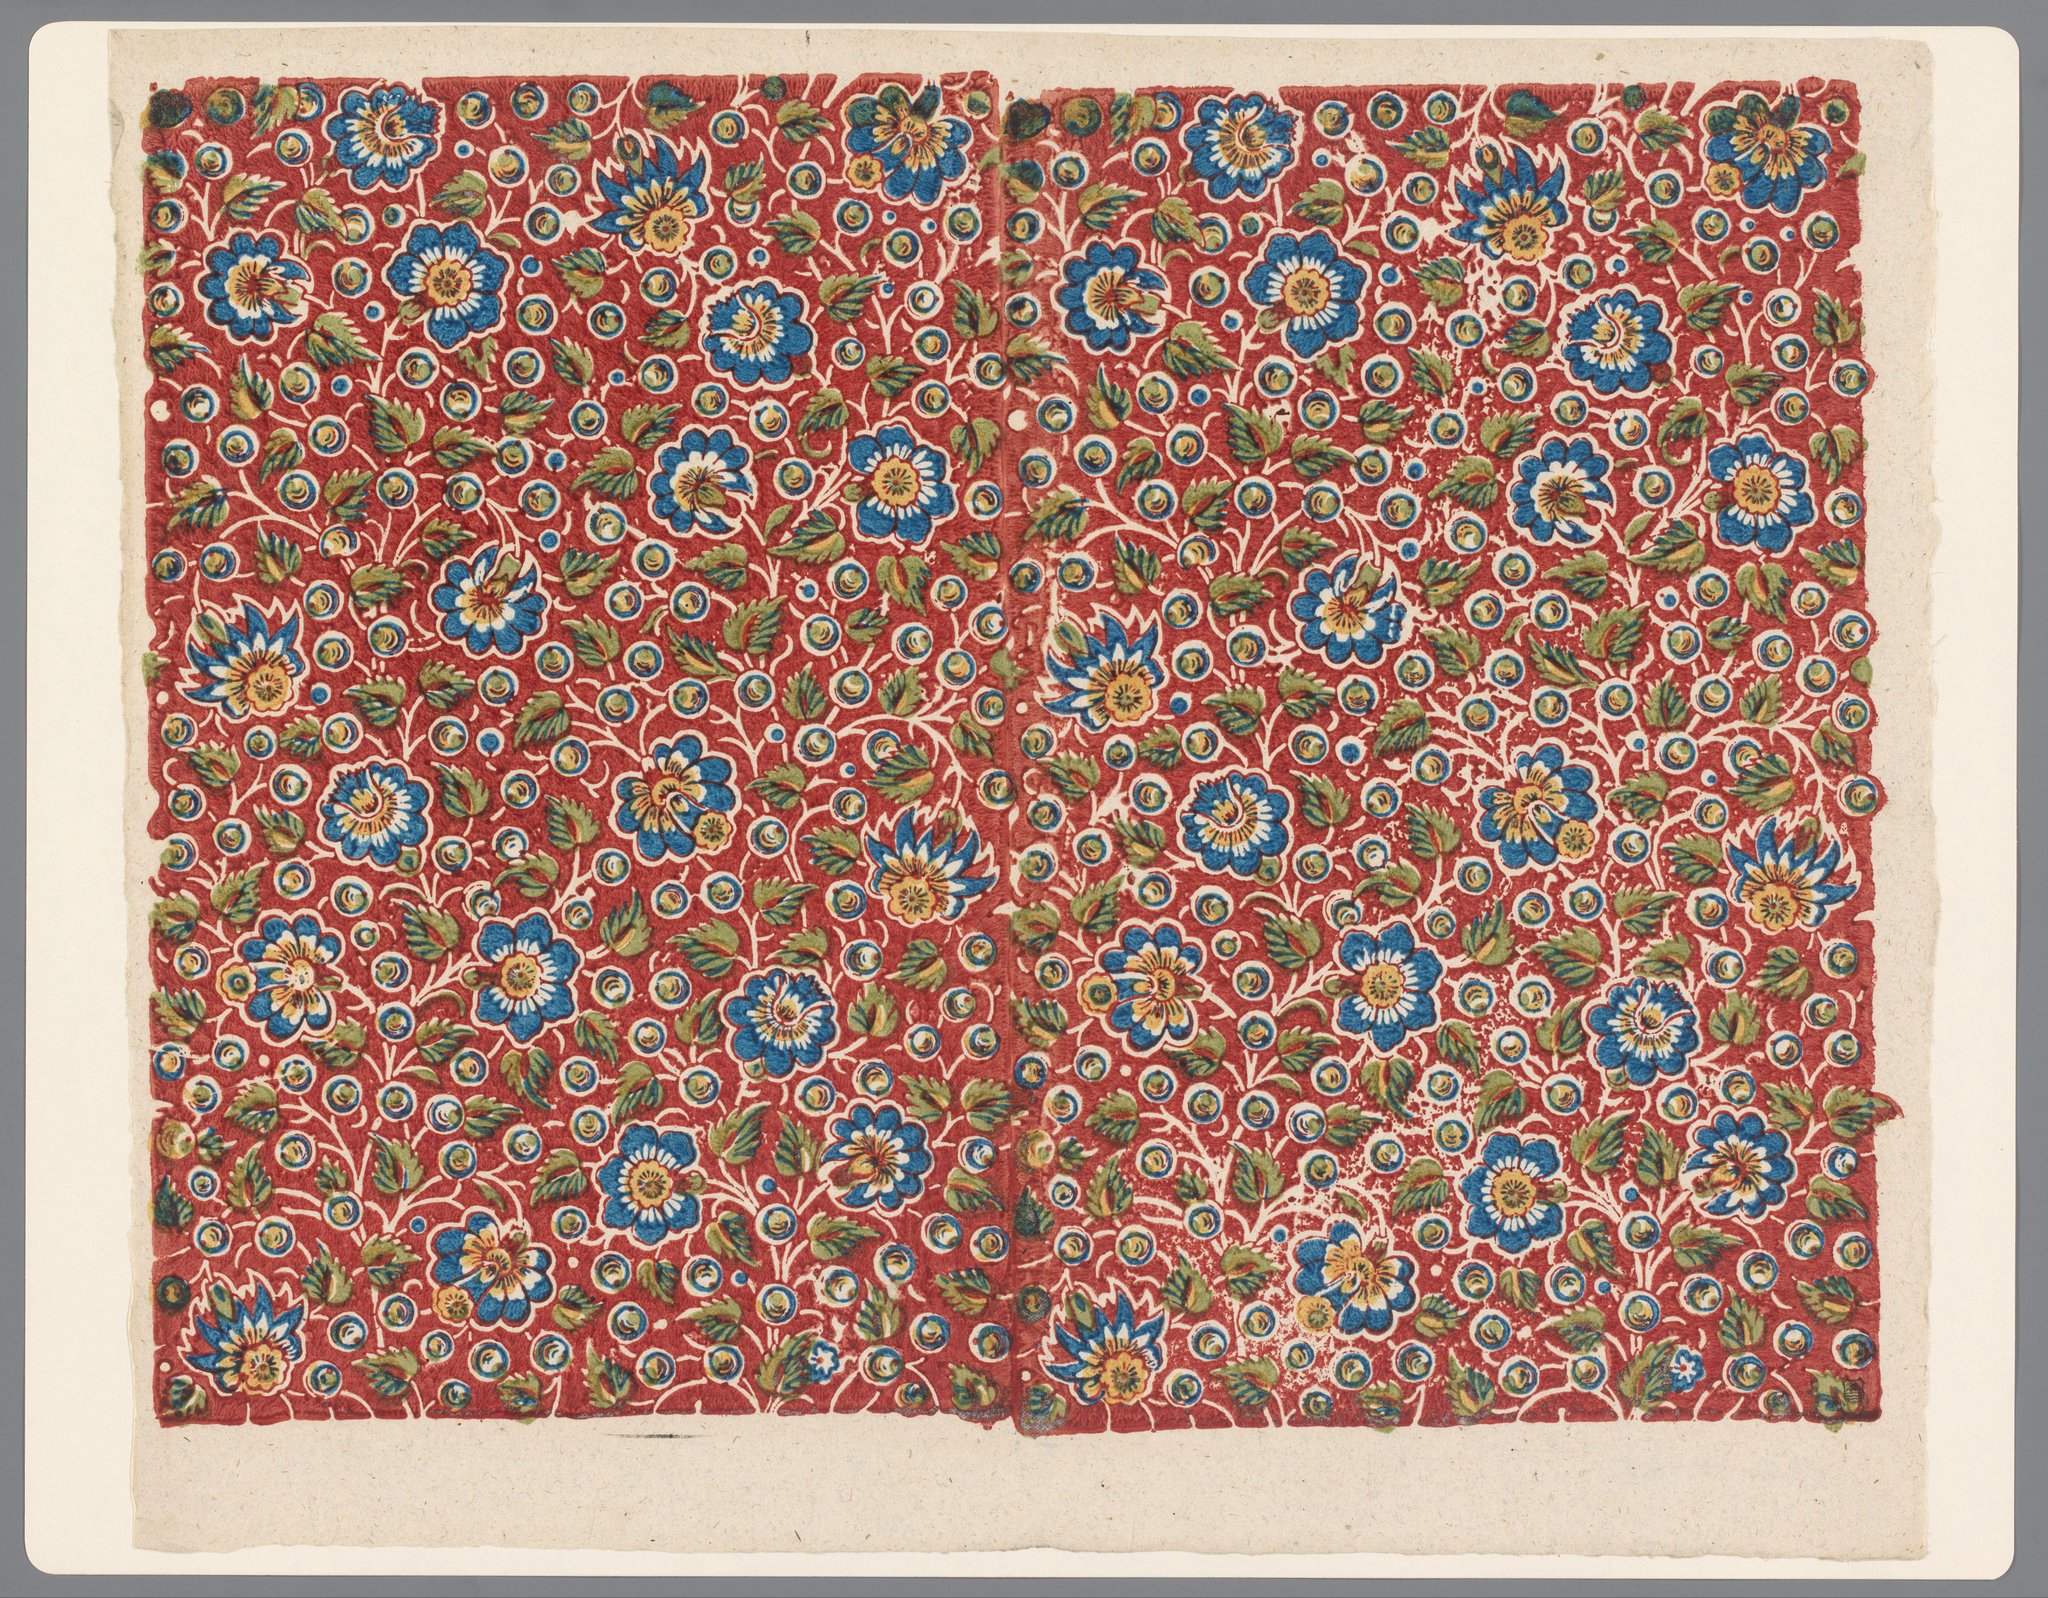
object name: printed paper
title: Blad met strooipatroon van uitgespaarde bloemen en vruchten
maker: Anonymous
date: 1700-1850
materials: paper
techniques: printing block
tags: ornament derived from plant forms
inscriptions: collector's mark: Lugt 2760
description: Blad met strooipatroon van uitgespaarde bloemen en vruchten.